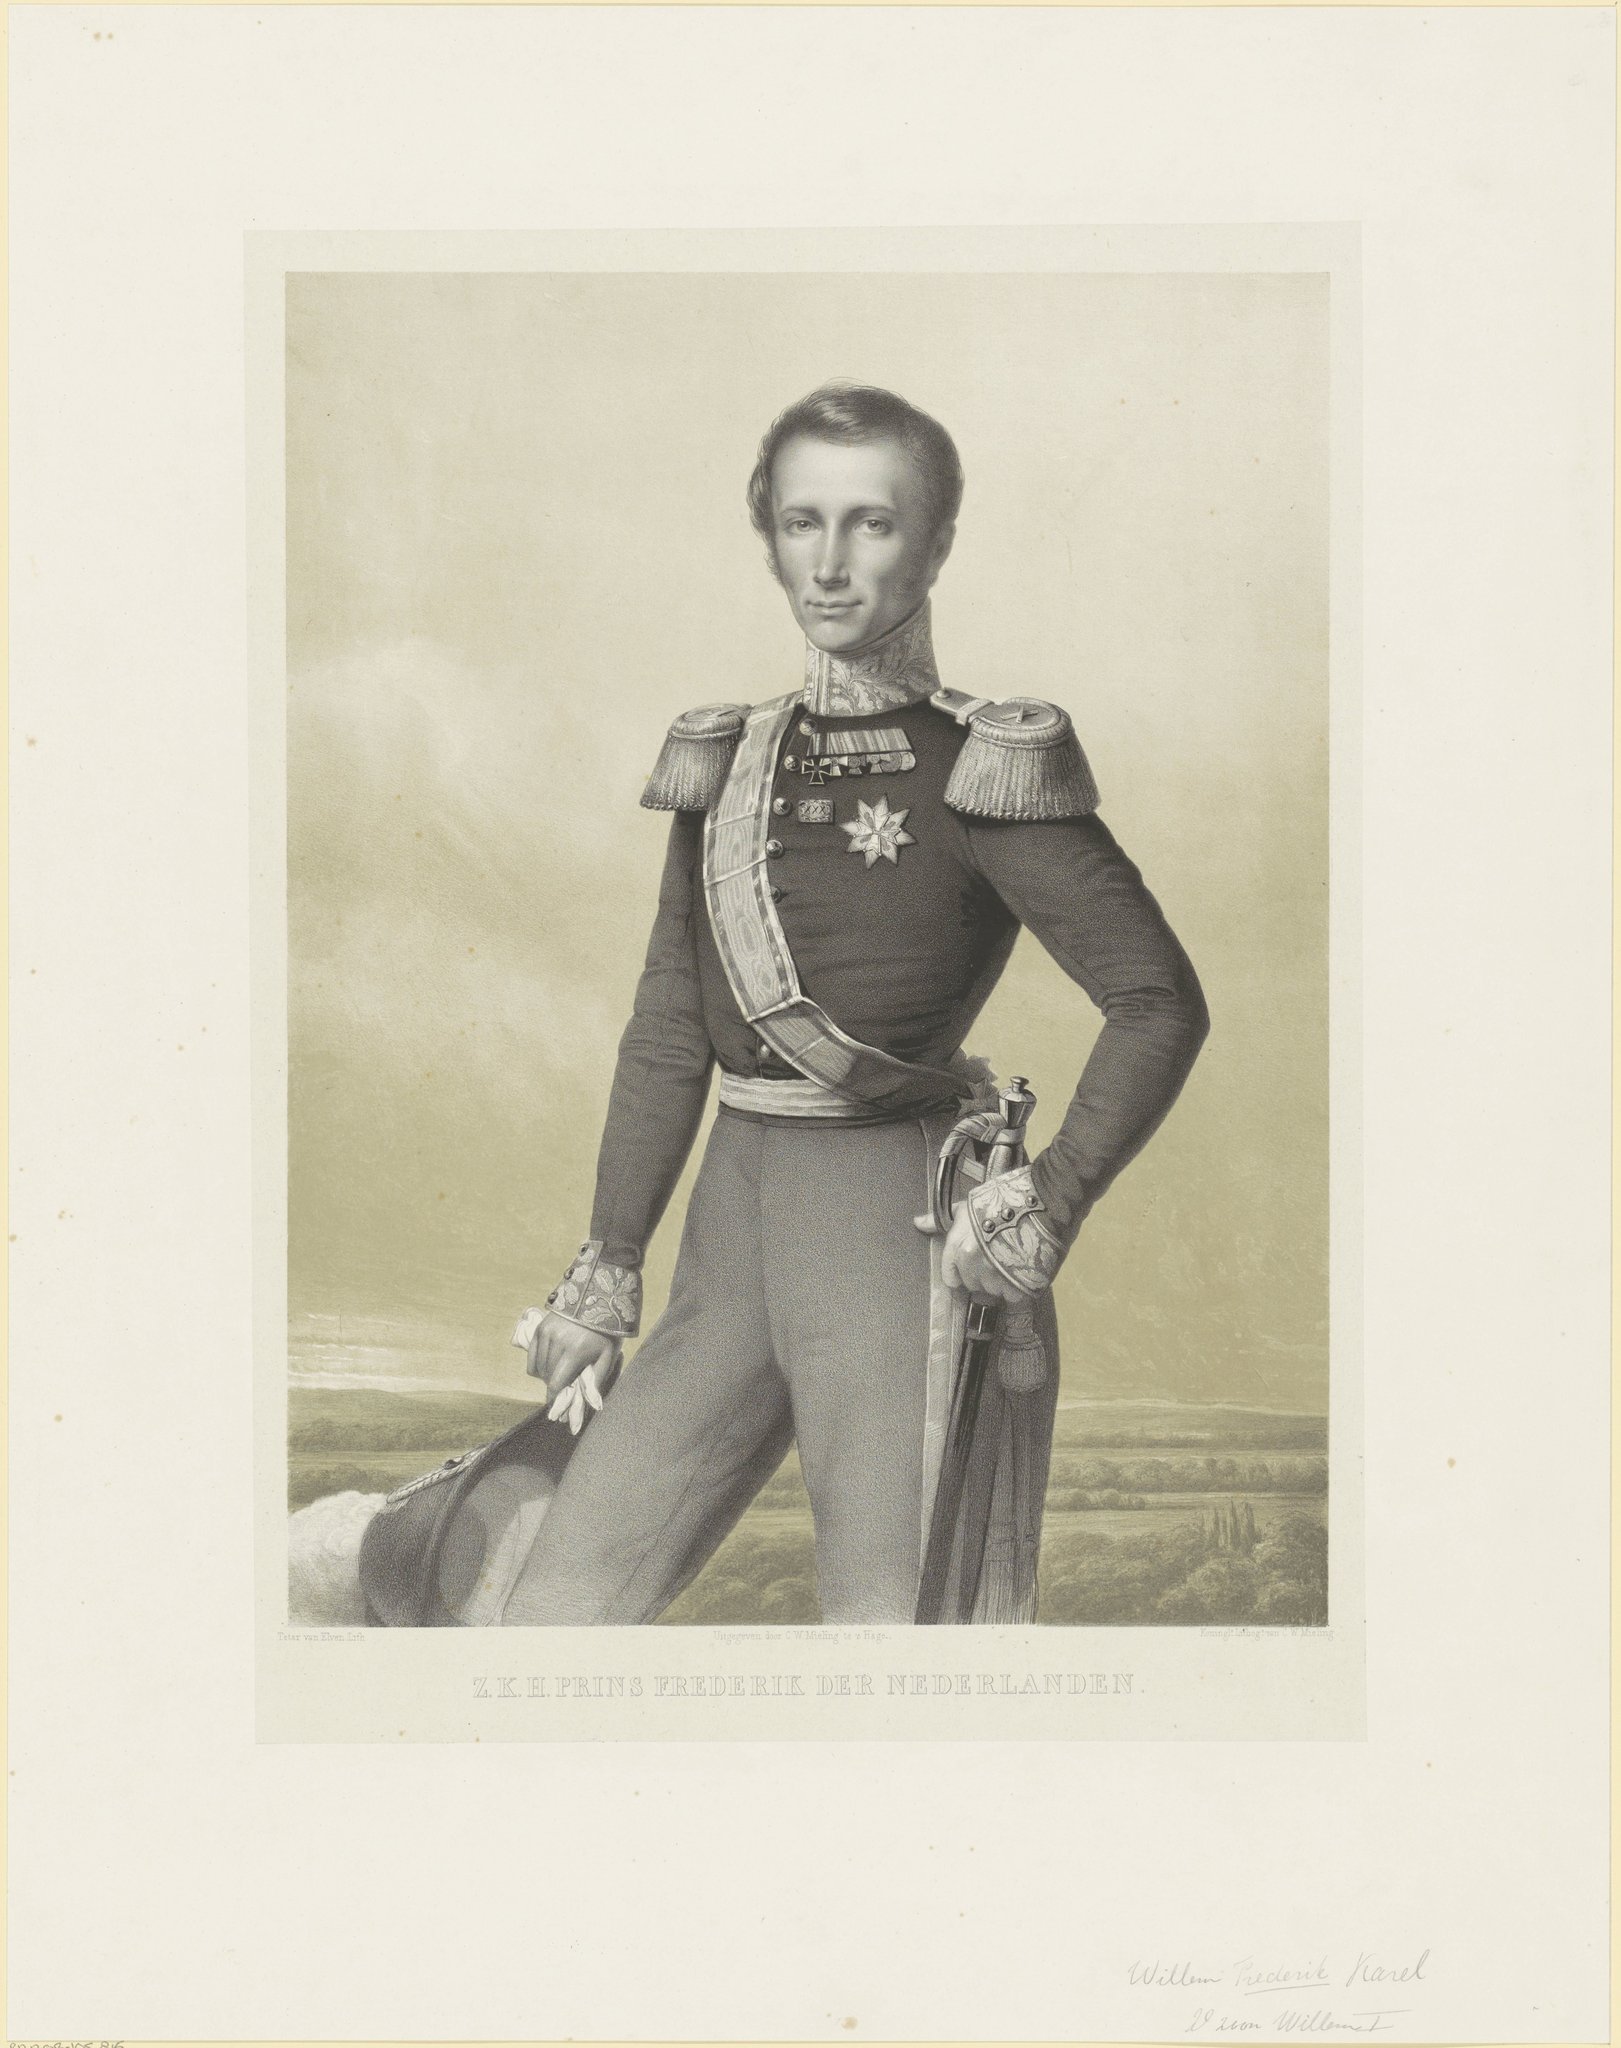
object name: print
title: Portret van Frederik, prins der Nederlanden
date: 1825-1871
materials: paper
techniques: lithograph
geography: the hague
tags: berlin, frederik (prins der nederlanden)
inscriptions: collector's mark: Lugt 963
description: De hier vermelde titel verwijst naar de hoogst verkregen titel van de geportretteerde, niet per se naar de titel die de geportretteerde op deze voorstelling draagt.